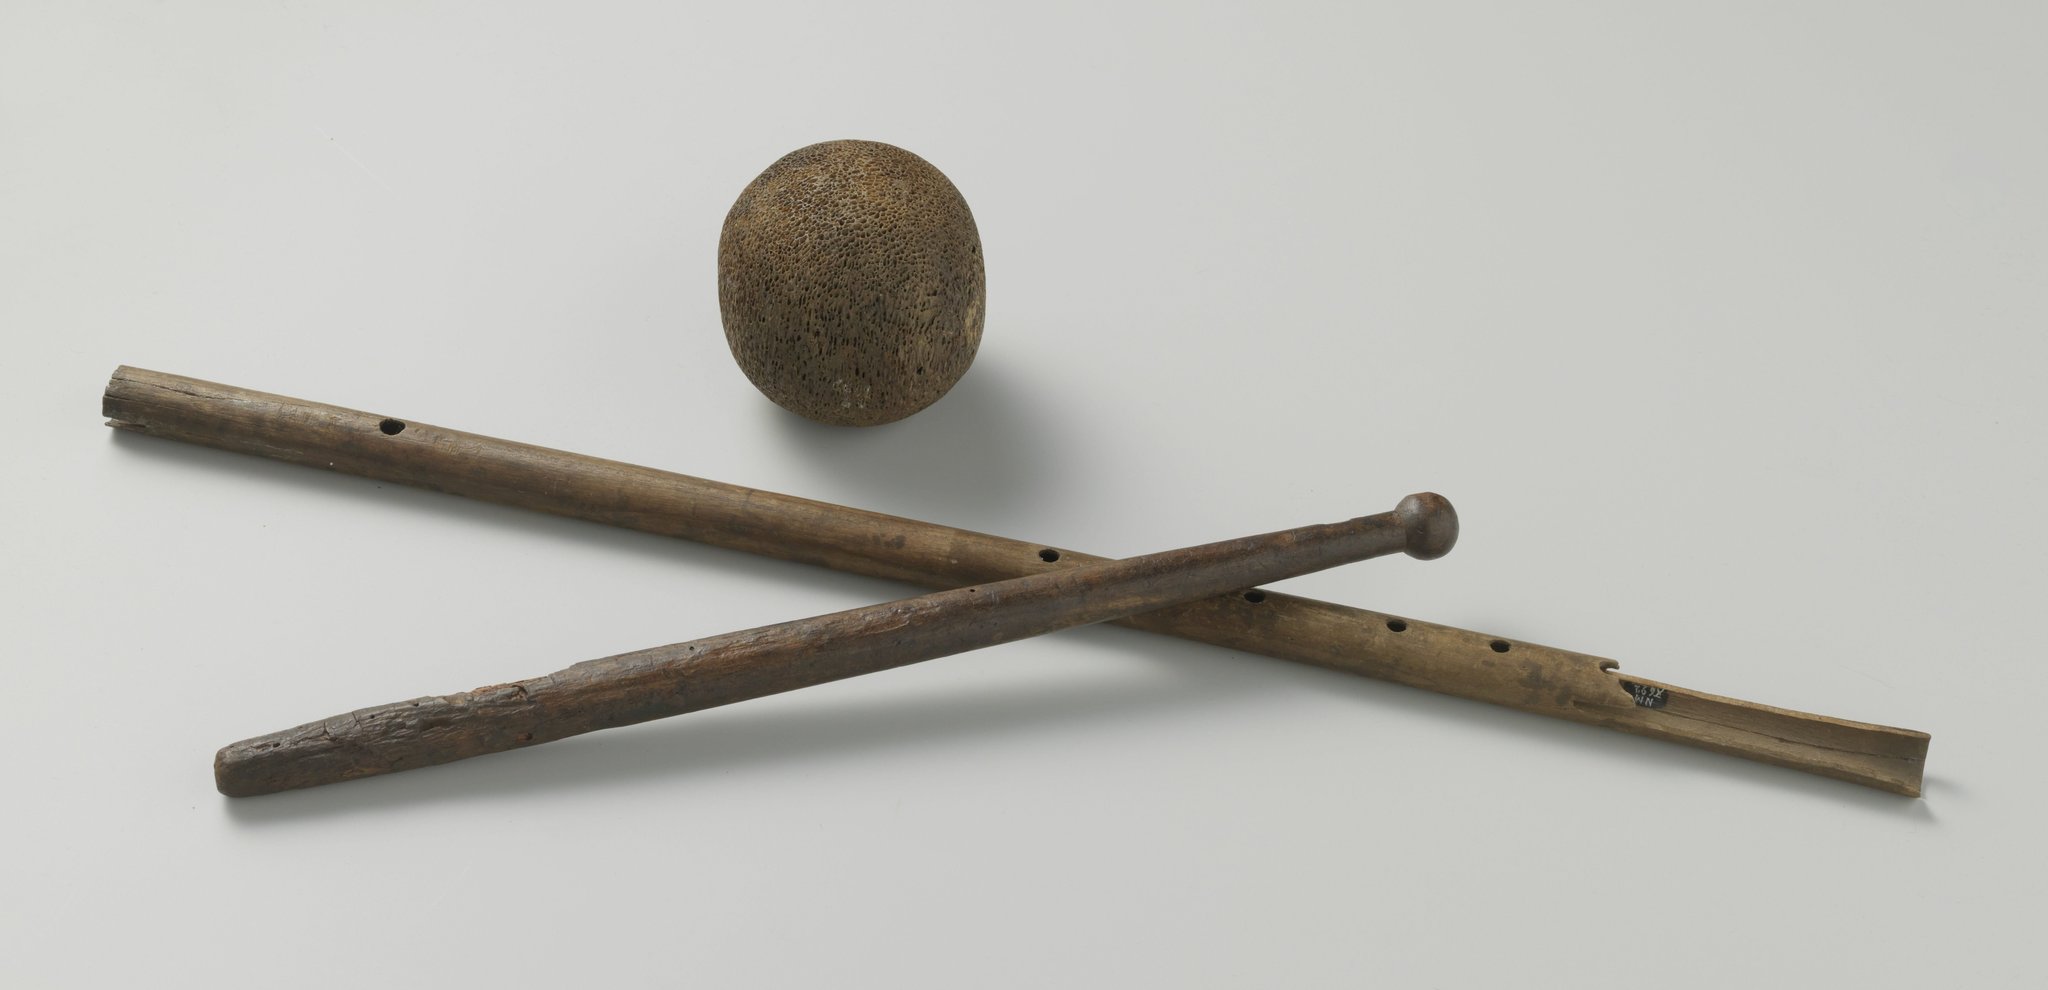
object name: bal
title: Personal effects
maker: Anonymous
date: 1590-1596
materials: bone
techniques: cutting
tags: willem barendsz., amsterdam, jacob van heemskerck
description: Each crewman had his own sea chest for his personal belongings. These wooden chests have since perished, only the locks and little keys remain. To kill time, the men made music and played sports. A drumstick and a flute were found on Nova Zembla. The ball is made of whalebone and was used to play ‘kolven’, a kind of hockey. The little comb was used to remove headlice.